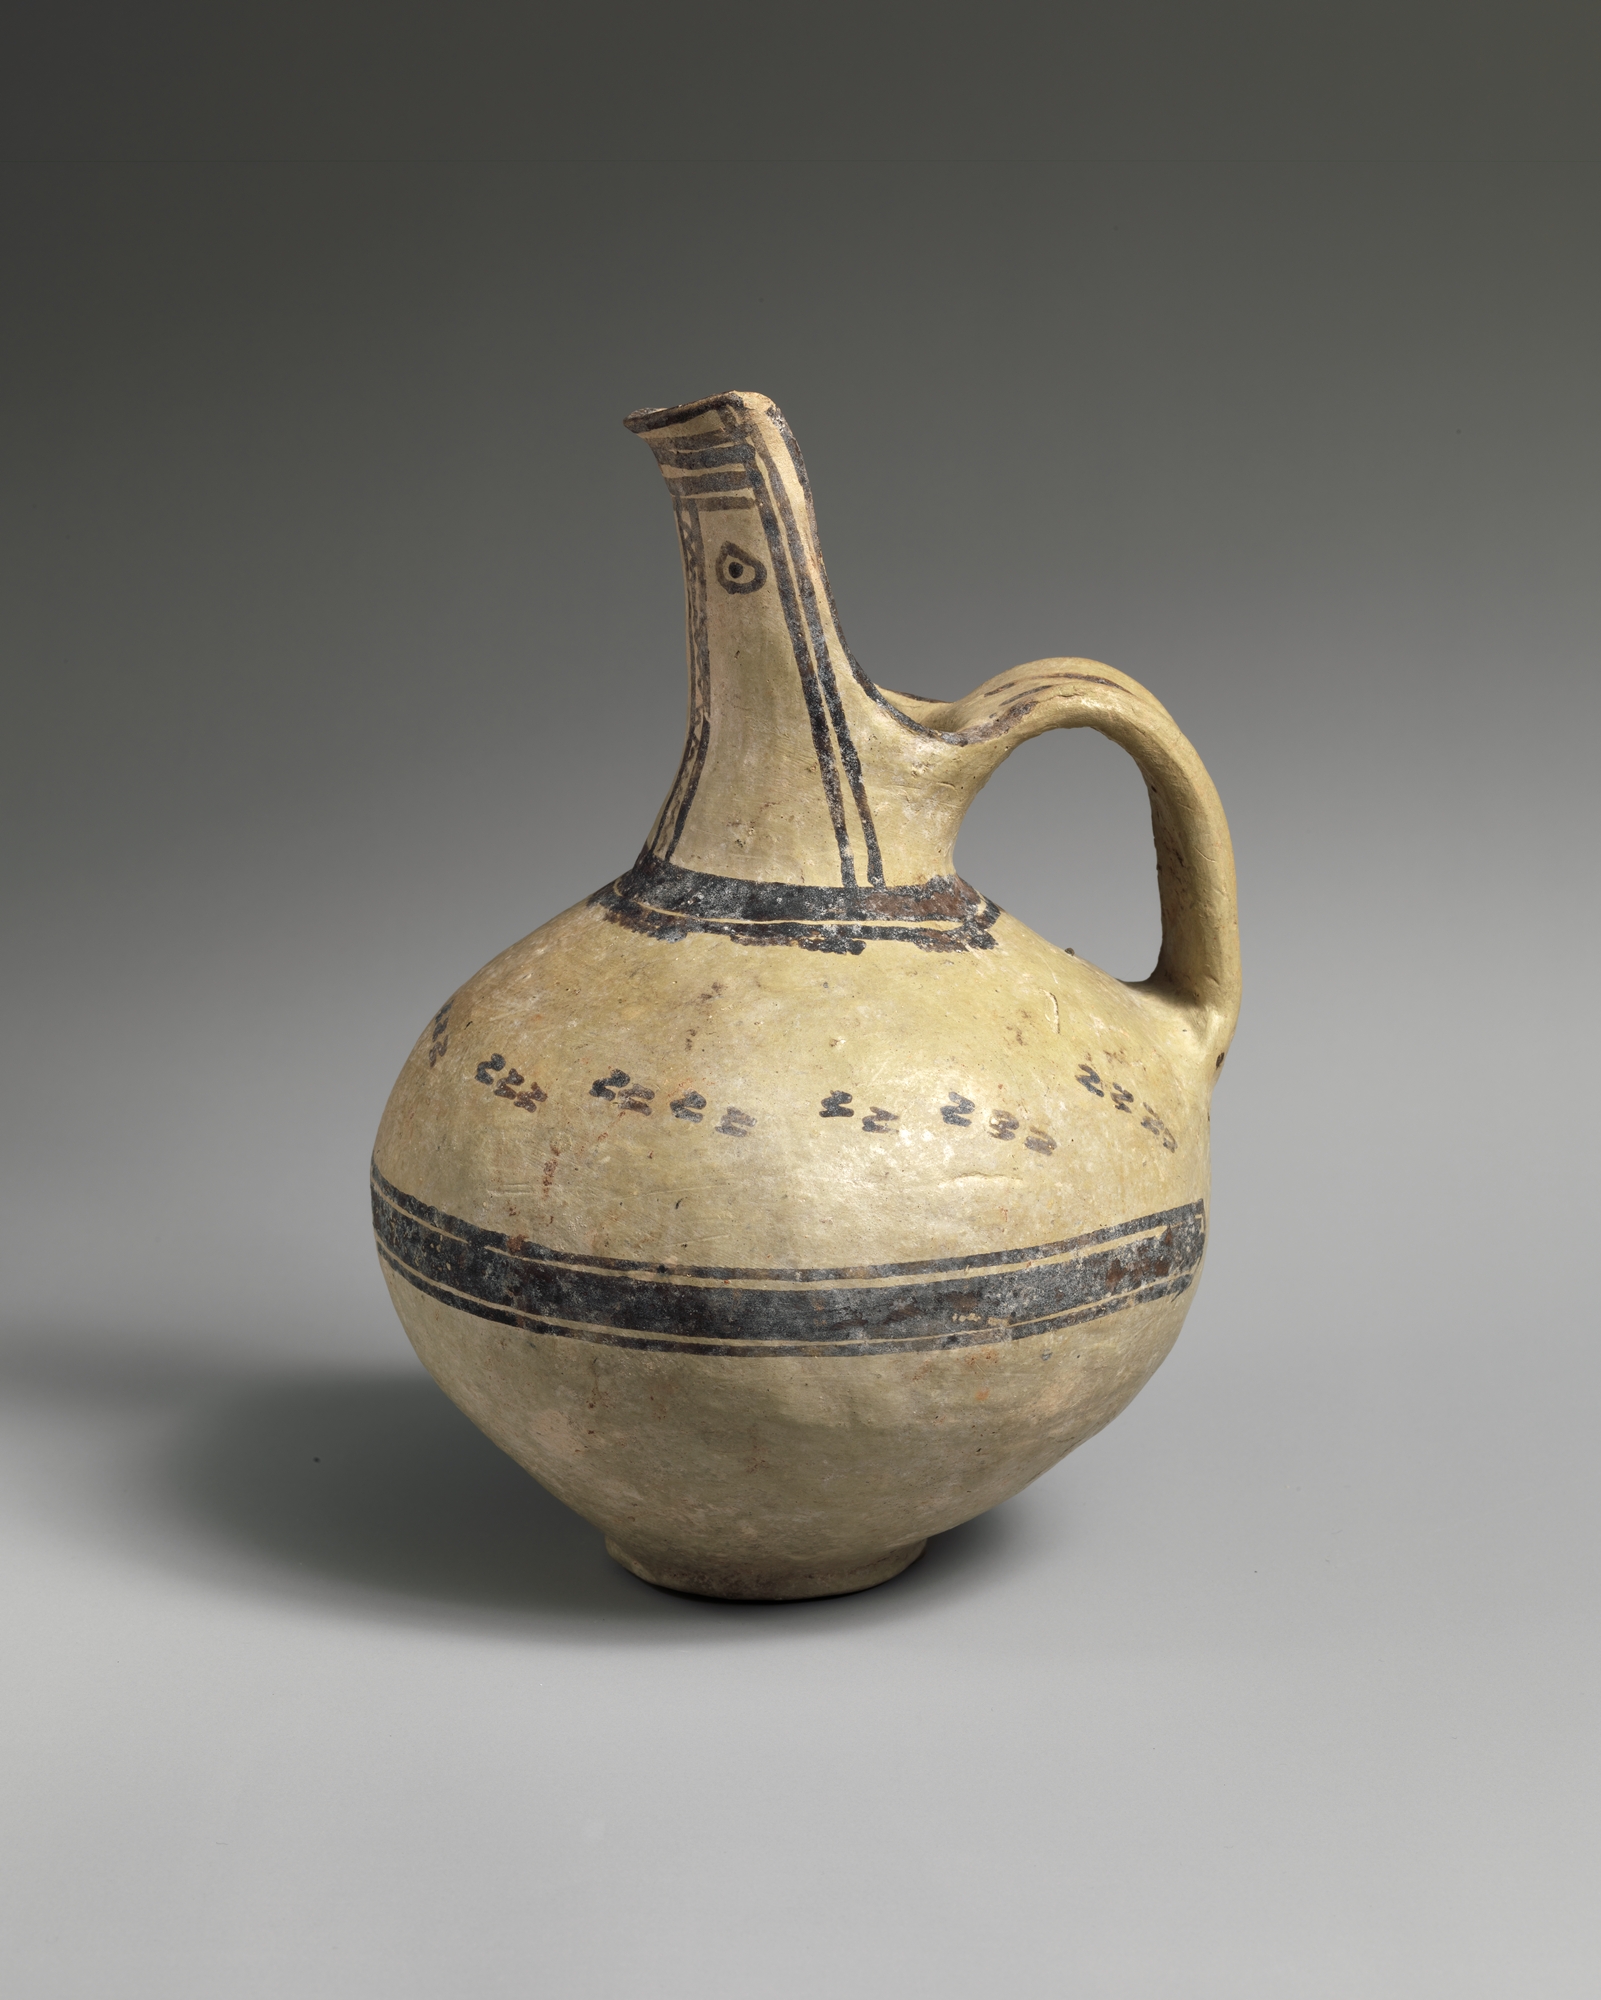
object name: jug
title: Terracotta beak-spouted jug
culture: helladic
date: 1750-1700 BCE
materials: terracotta